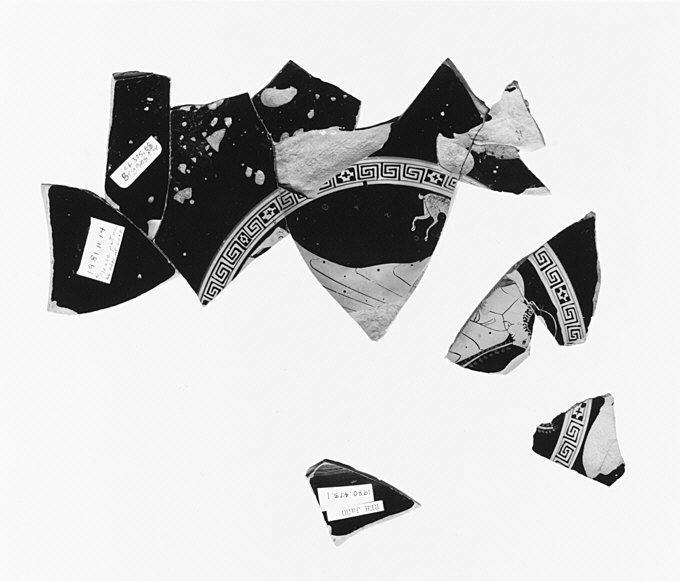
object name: kylix fragment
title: Kylix fragments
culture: greek, attic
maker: brygos painter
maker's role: artist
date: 480 BCE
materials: terracotta